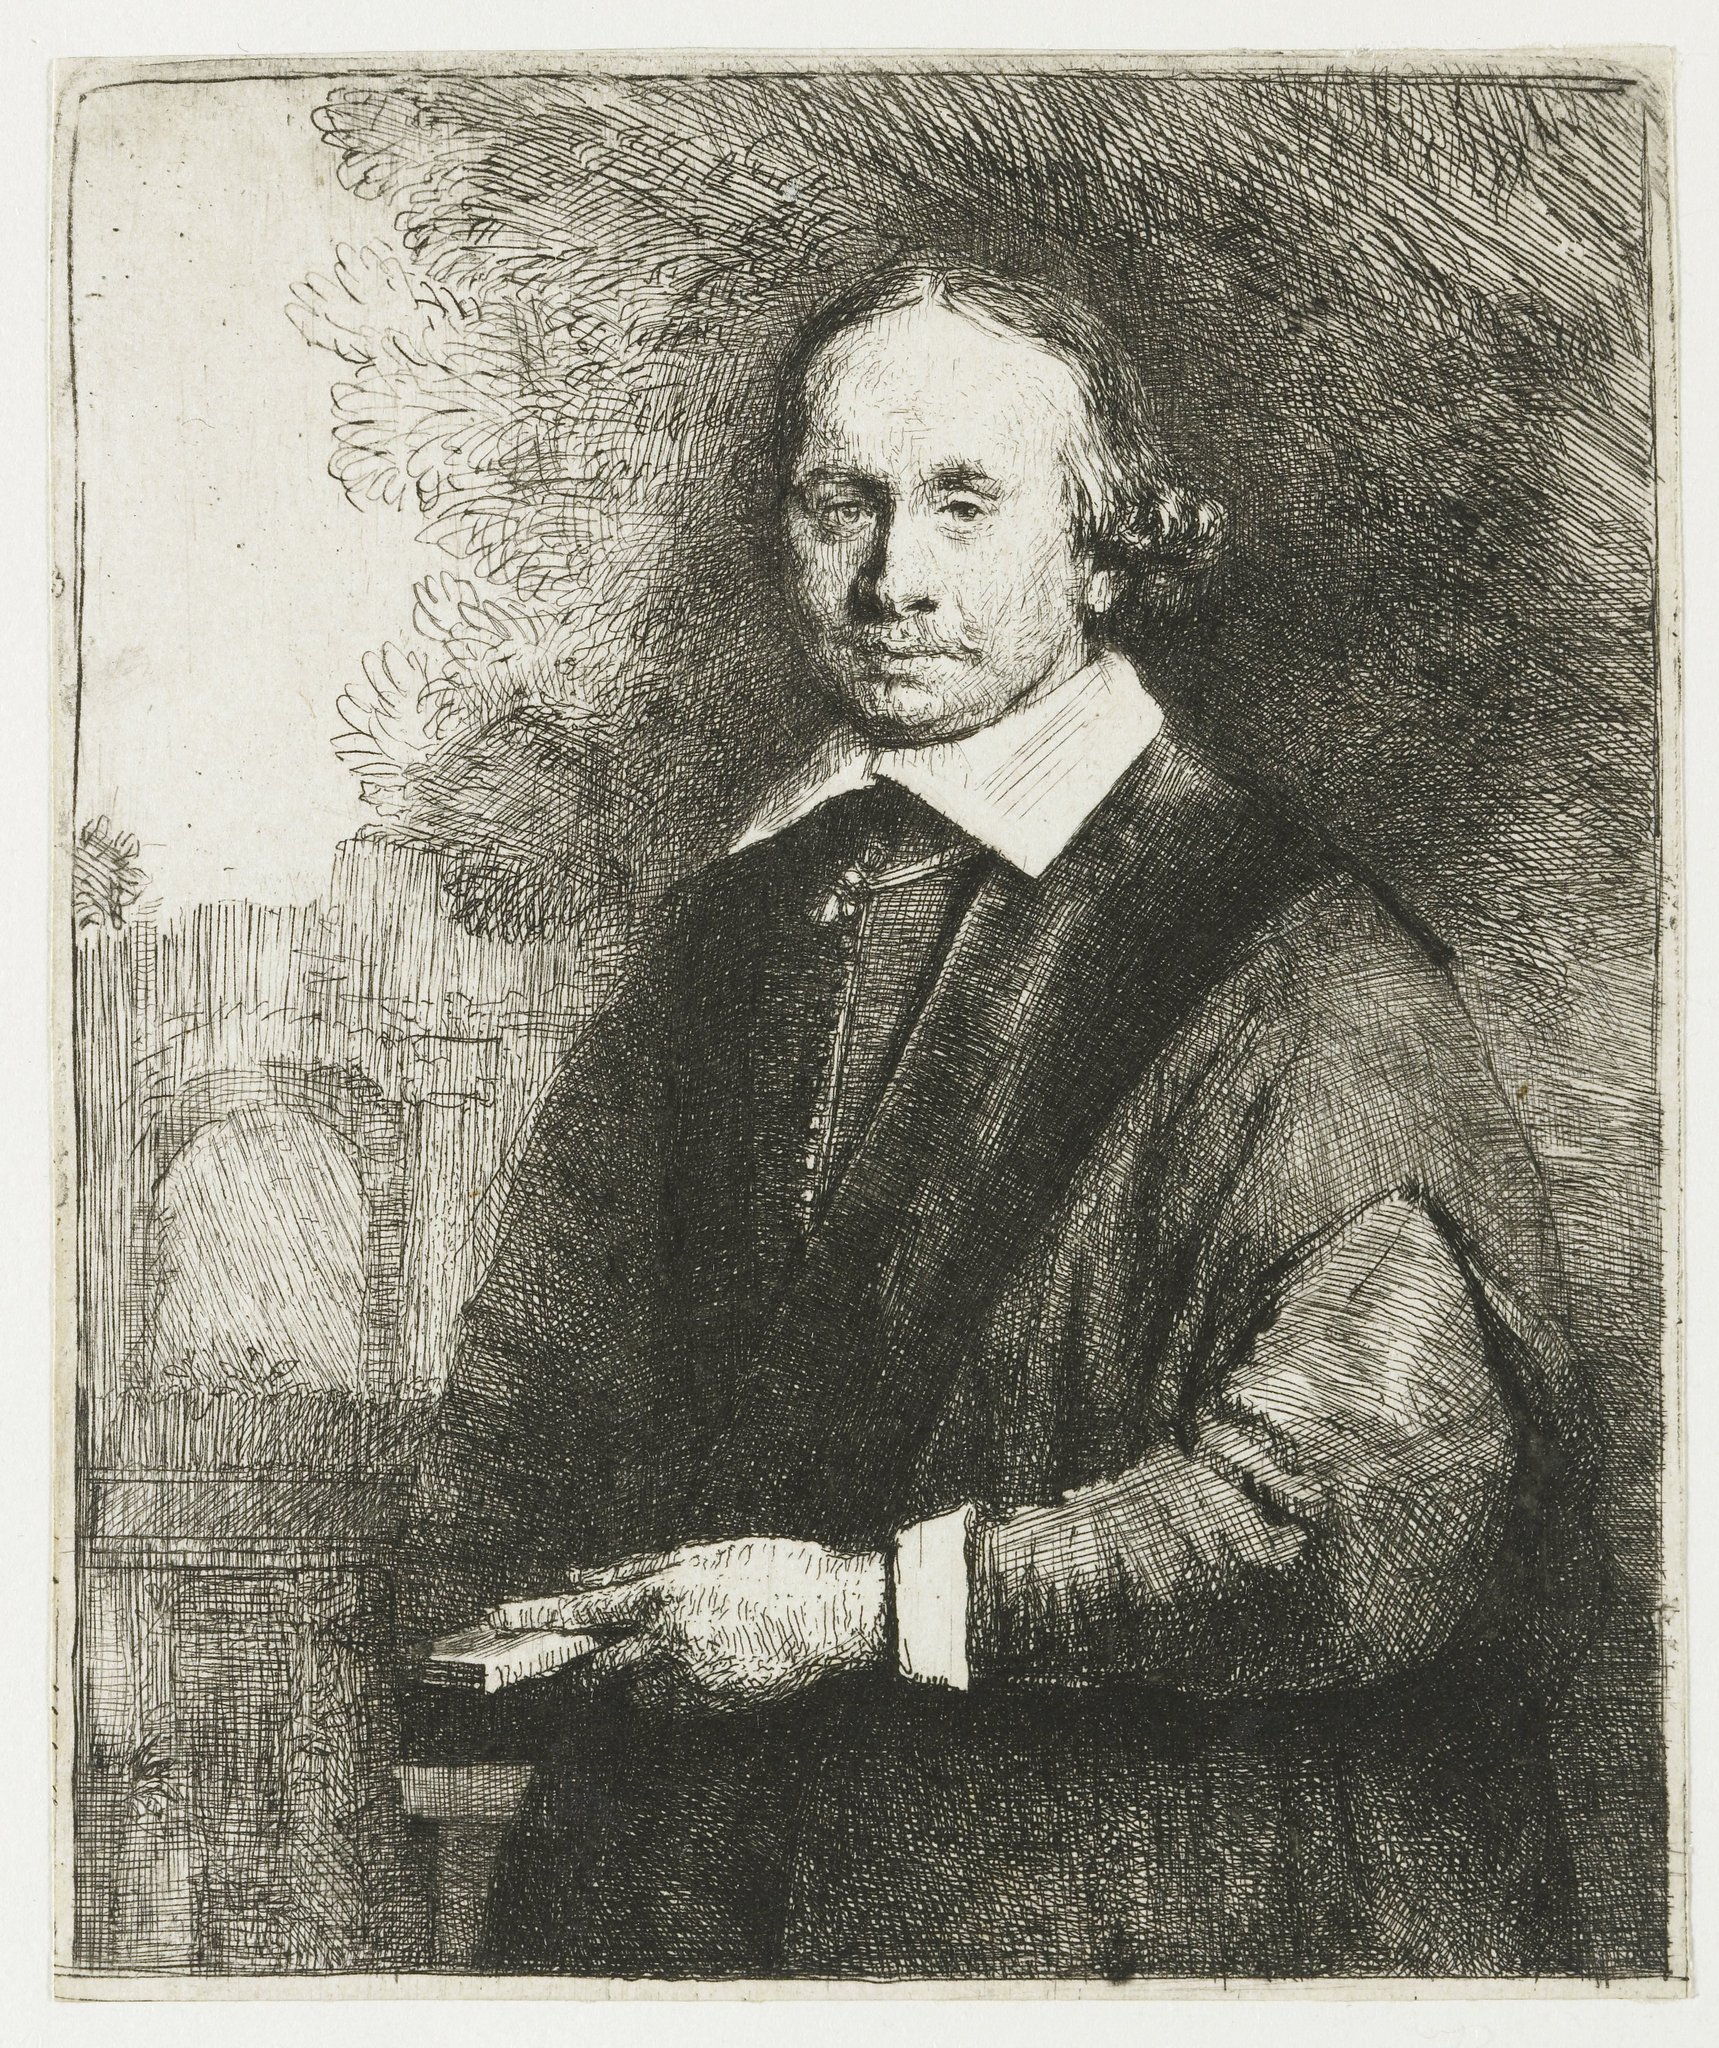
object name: print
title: Jan Antonides van der Linden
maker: rembrandt van rijn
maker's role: draughtsman, painter, print maker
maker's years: 1606-1669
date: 1665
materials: paper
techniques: drypoint, etching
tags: enkhuizen, jan antonides van der linden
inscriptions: collector's mark: Lugt 2165